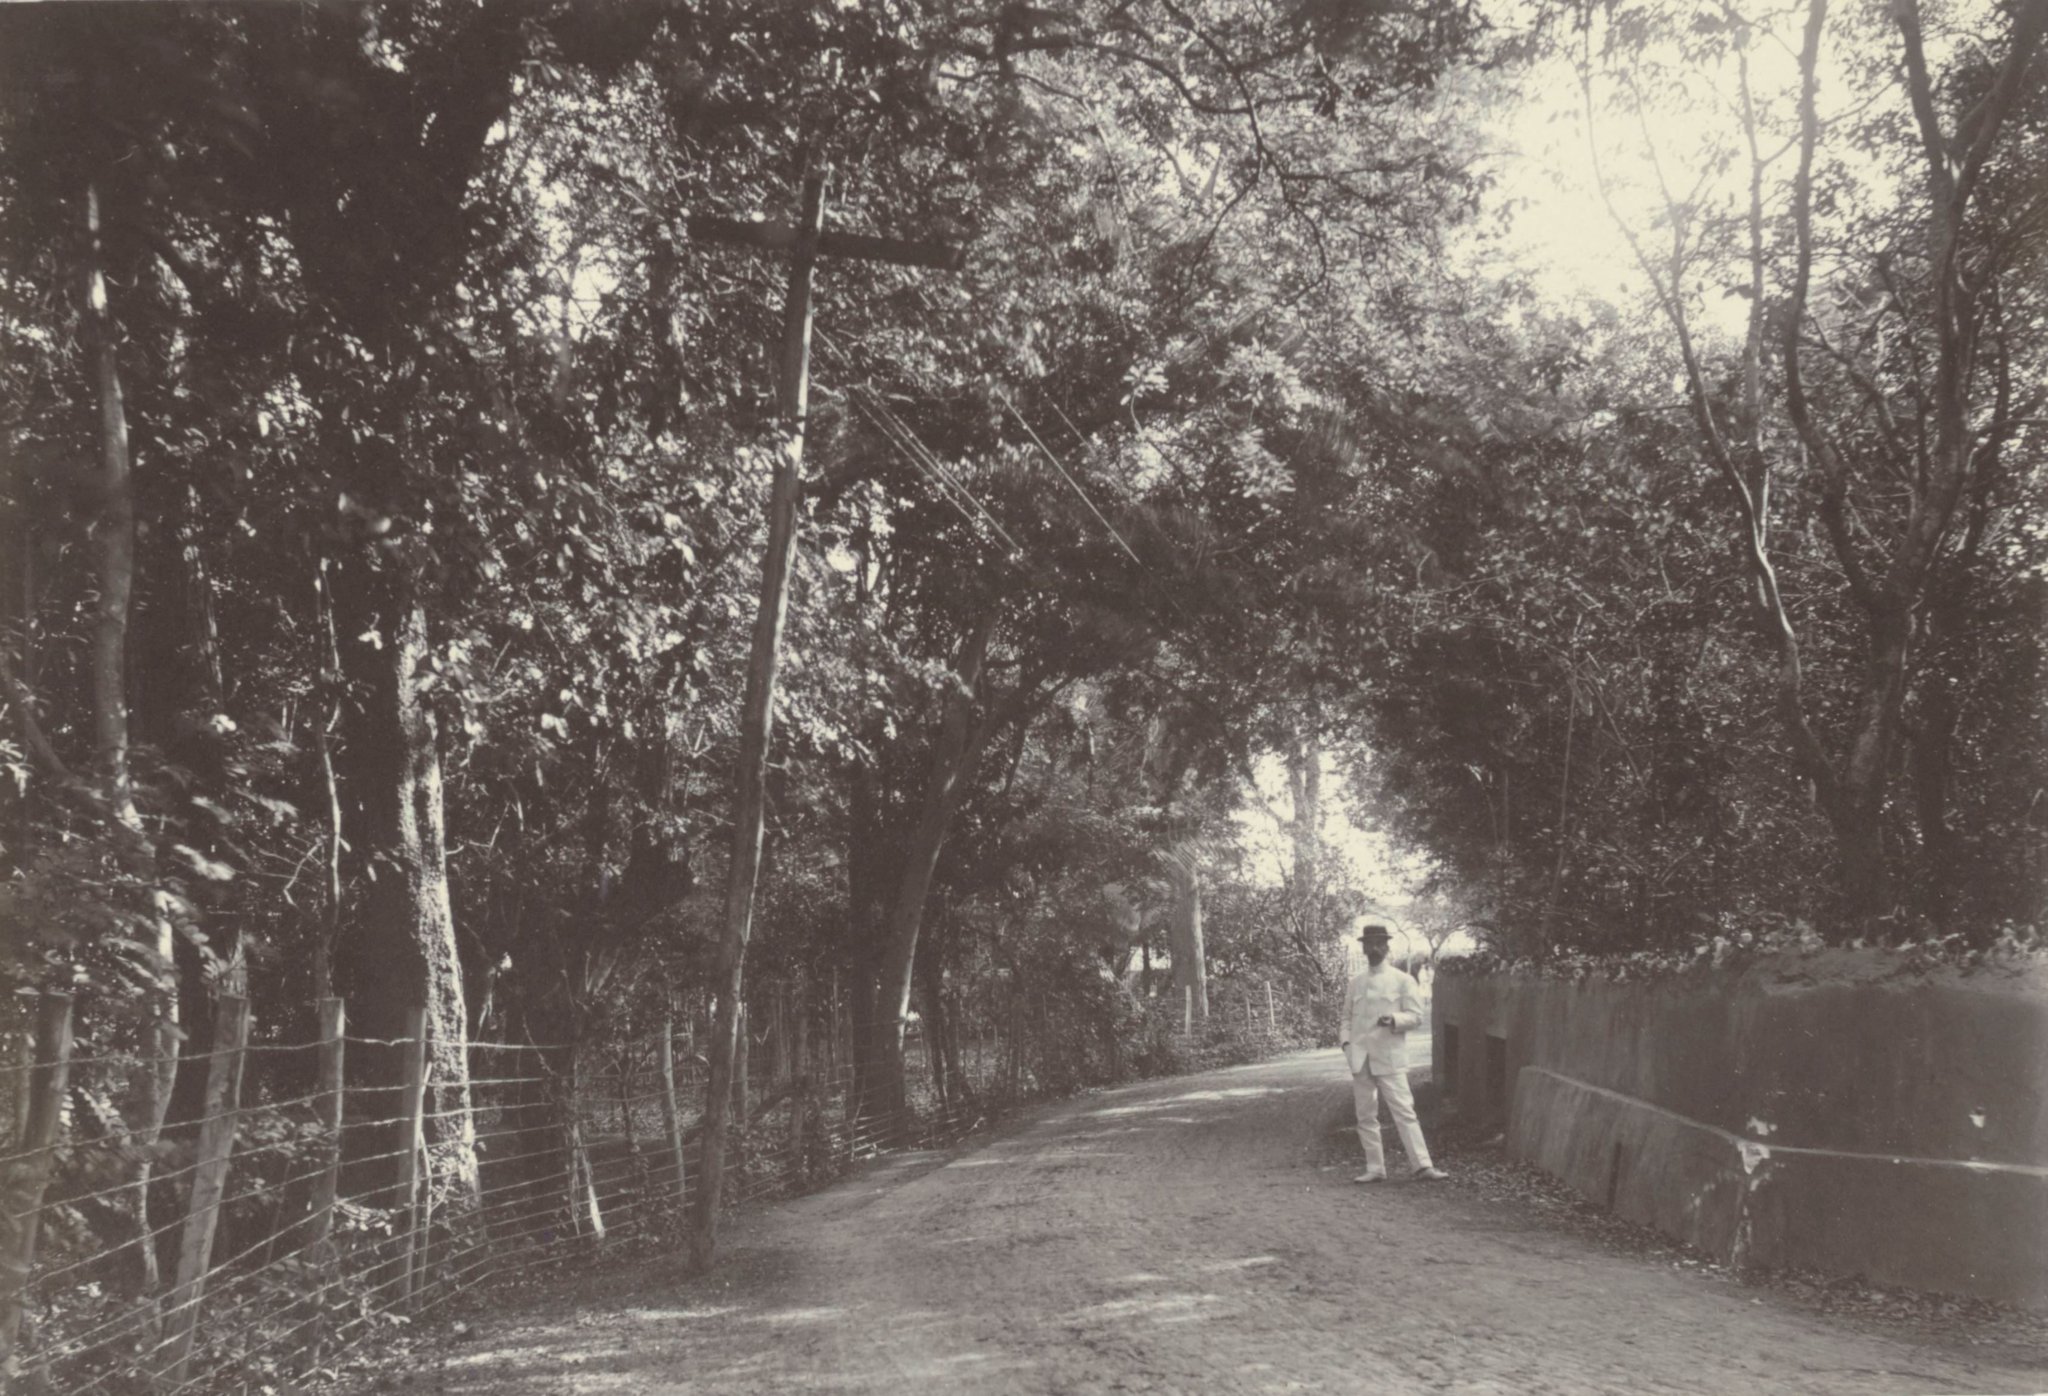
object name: photograph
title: Weg naar Zuikertuintje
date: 1906-1910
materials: photographic support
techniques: photography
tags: zuikertuintje, curaçao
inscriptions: inscription: ‘Weg naar Suikertuintje 't Rooi Catootje Curaçao Juni 1910 / de Heer Resler’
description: De weg naar het Zuikertuintje in het buurtschap Rooi Catootje in Willemstad, Curaçao, juni 1910. Onderdeel van het fotoalbum van de familie Boom-Gonggrijp in Suriname en Curaçao.